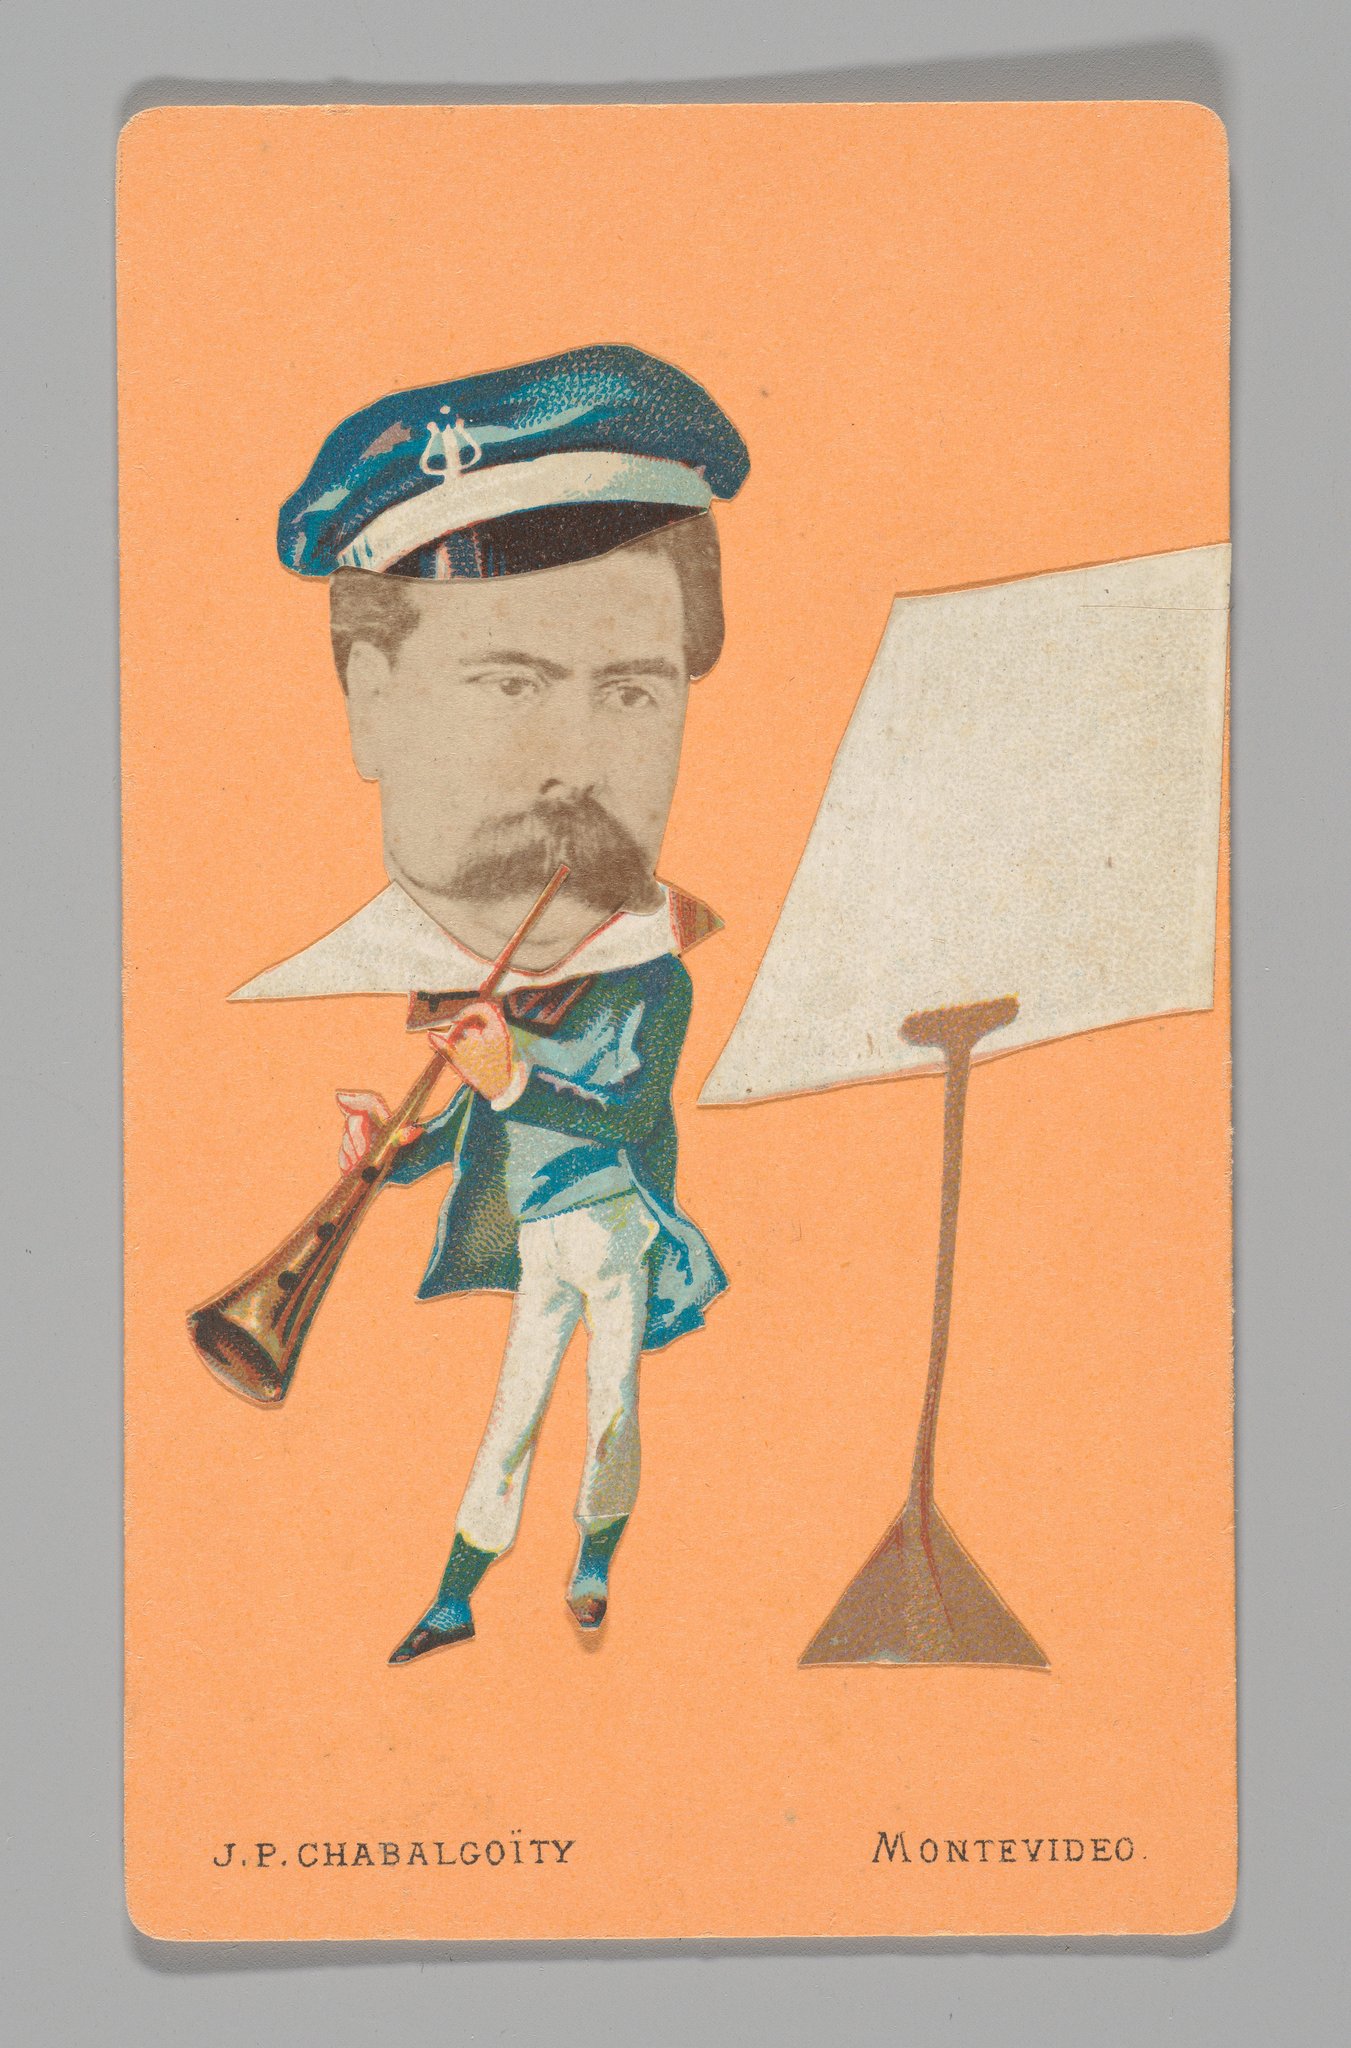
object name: carte de visite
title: [Photo Collage: Musician Playing Horn]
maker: juan pedro chabalgoity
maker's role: artist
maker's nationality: uruguayan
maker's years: 1848-1909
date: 1875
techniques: albumen silver print, lithograph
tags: men,horns,musicians